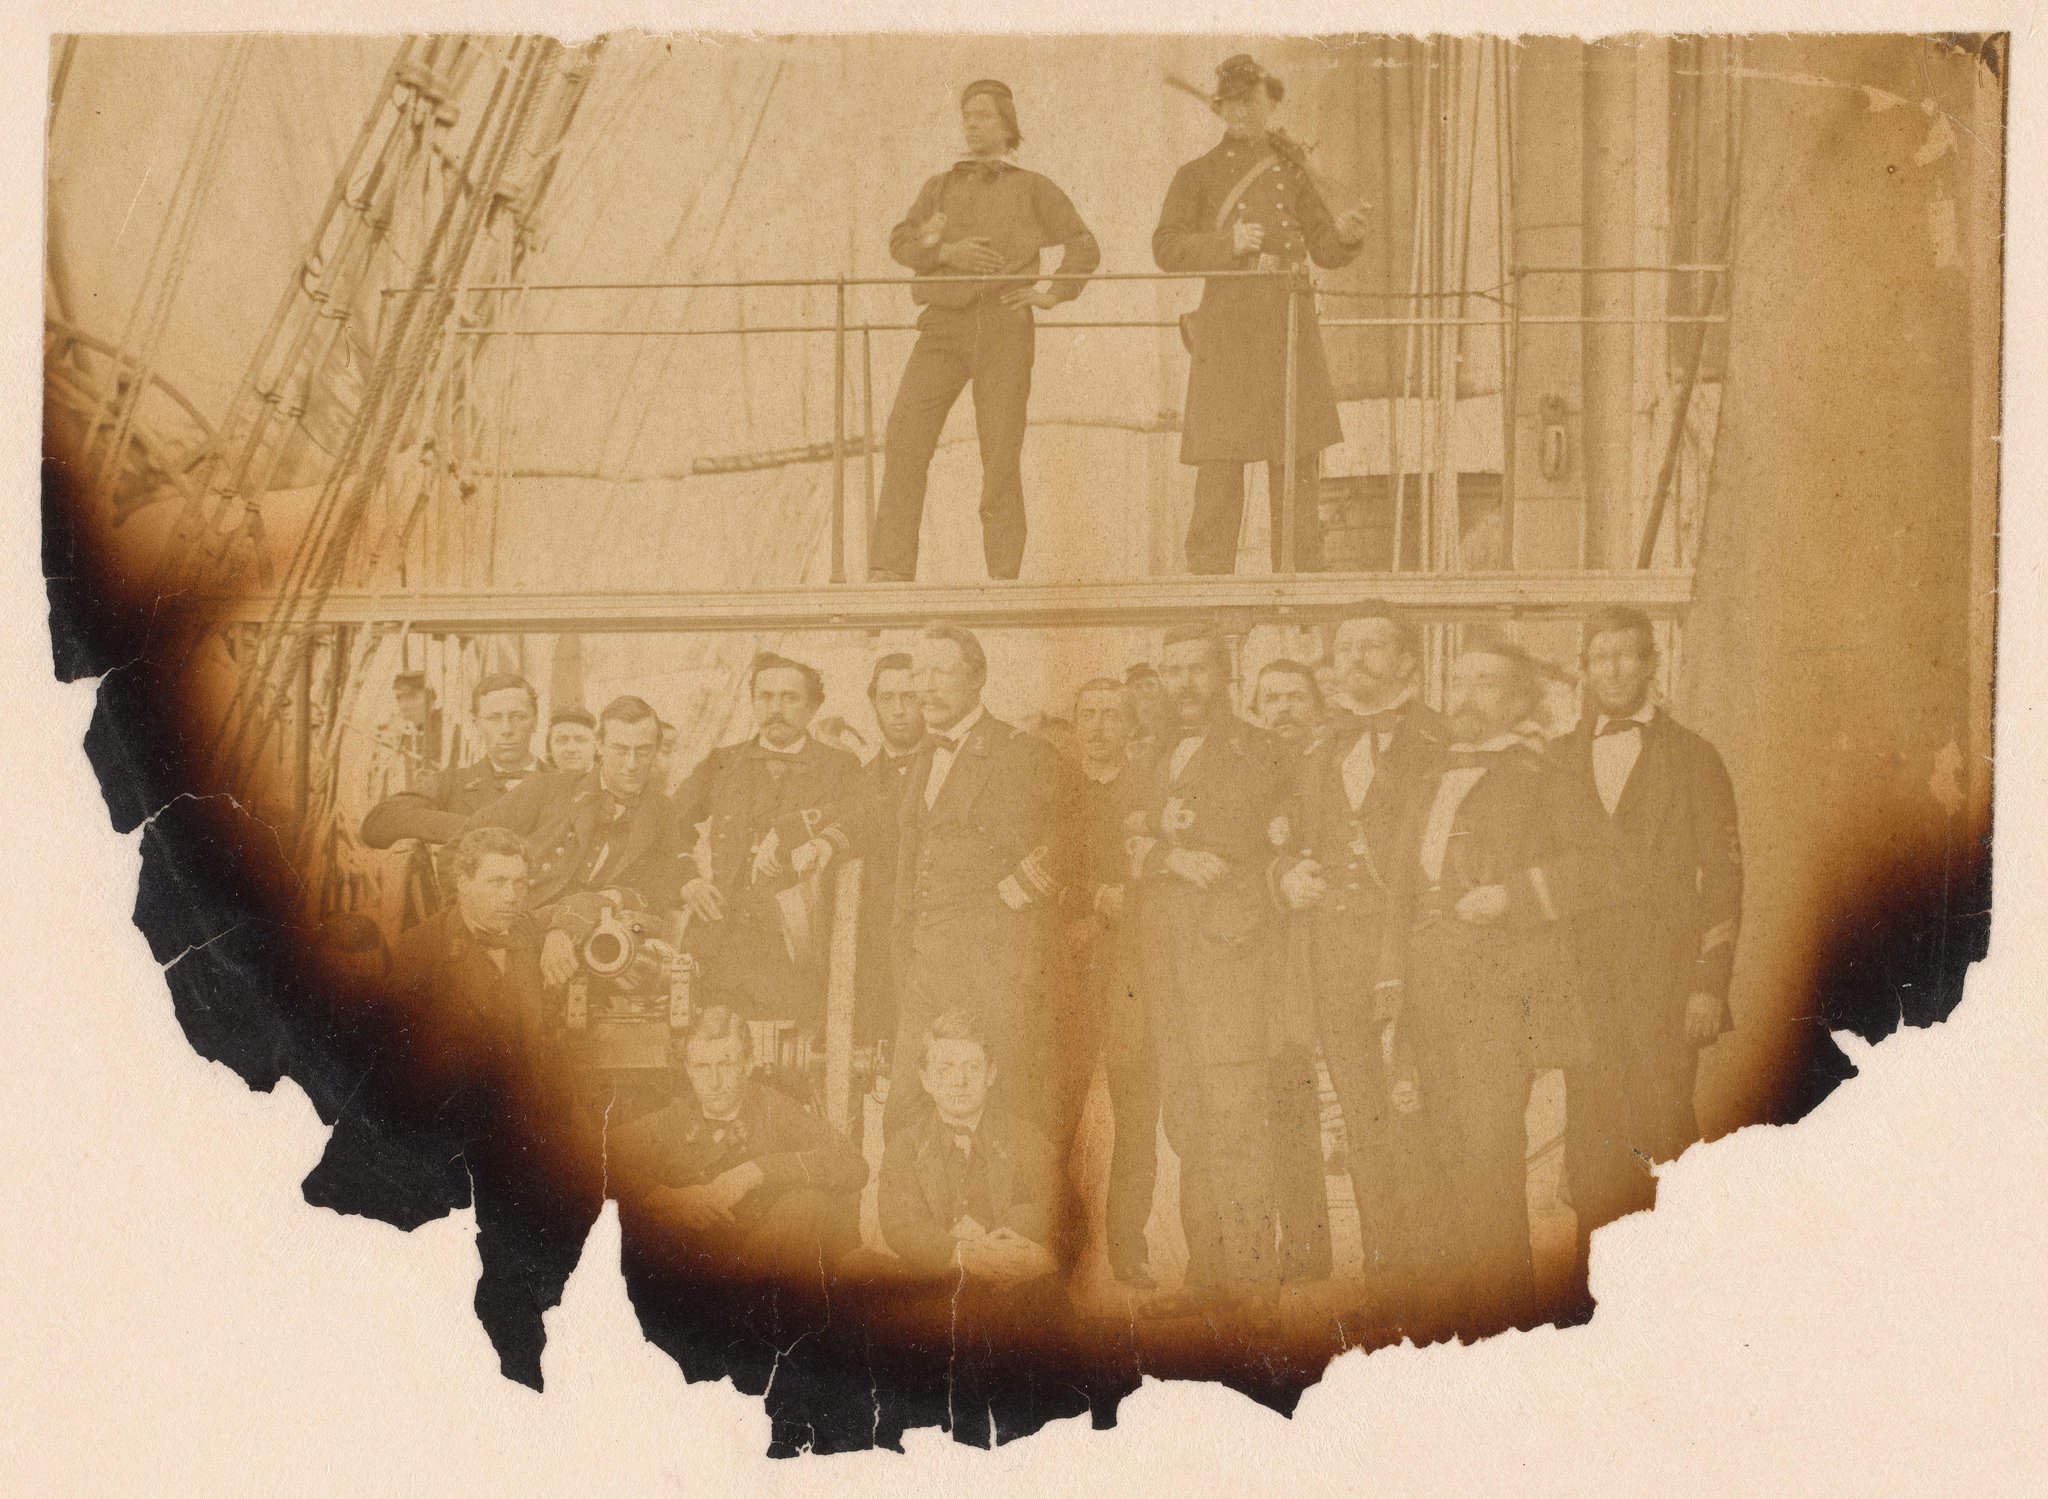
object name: photograph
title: Crew aboard the Medusa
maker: antoon bauduin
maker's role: amateurfotograaf, hoogleraar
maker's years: 1820-1885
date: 1864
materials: paper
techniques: albumen print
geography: japan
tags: crew ~ ship, japan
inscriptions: number: ‘163’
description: The Dutch Navy ship Medusa came under Japanese fire whilst crossing the Straits of Shimonoseki in 1863. Four sailors died. In this photo we see part of the ship’s crew, with on the left a cannon they seized from the Japanese a year later. Given the impossibility of photographing such momentous events, a group portrait offered a good alternative.